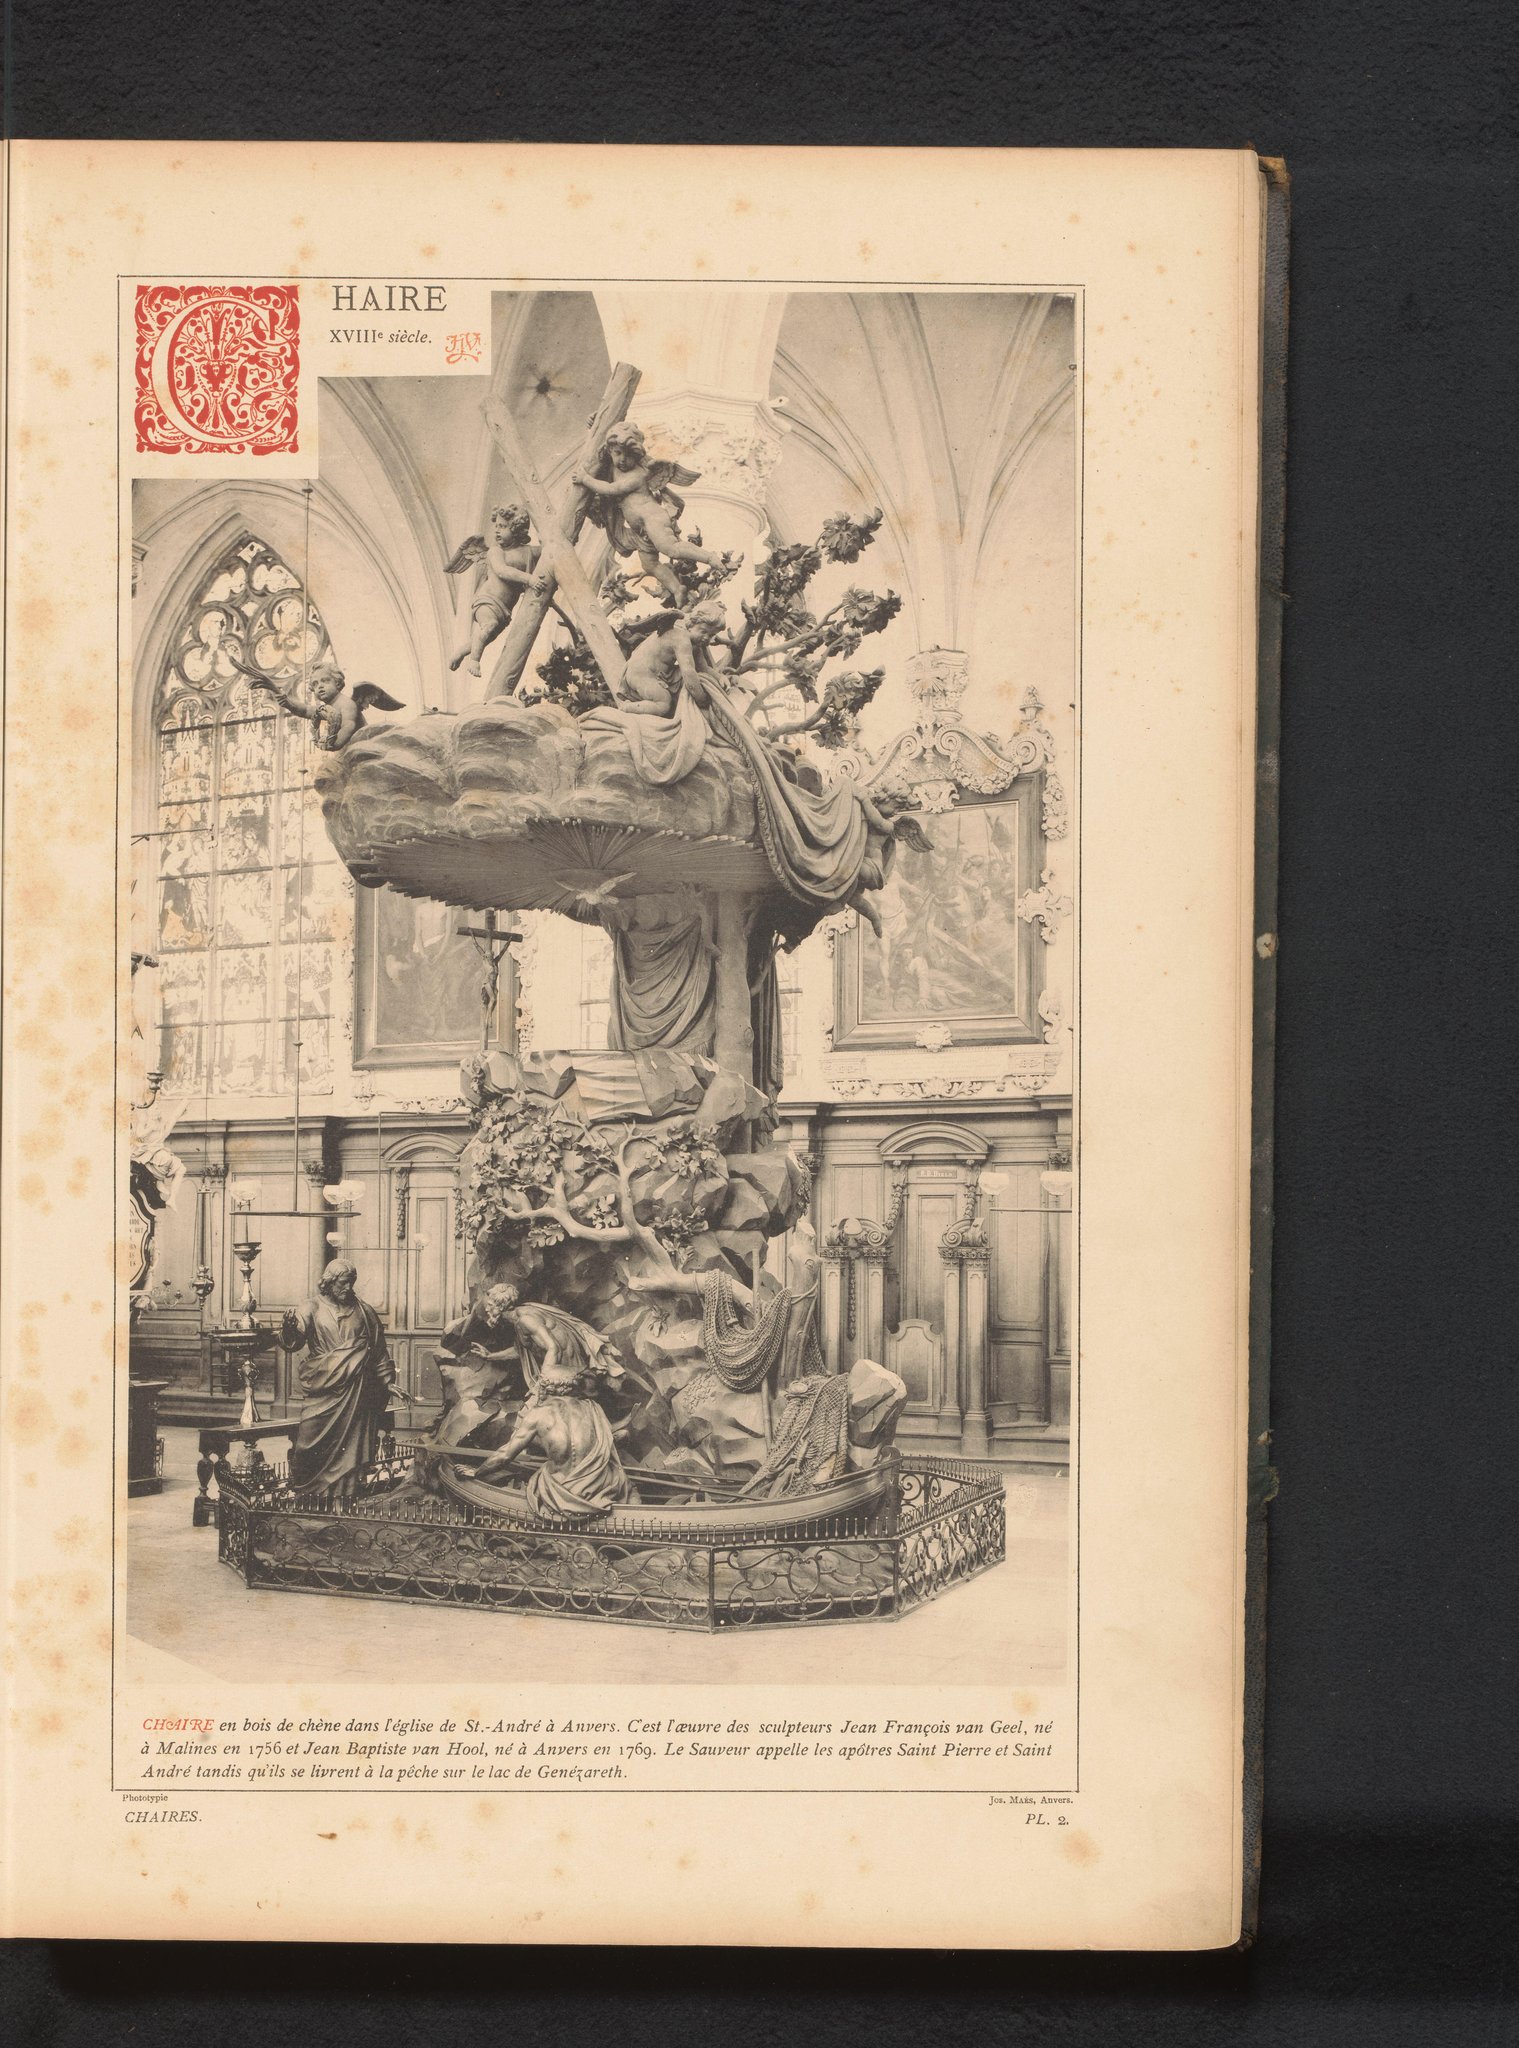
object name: photomechanical print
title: Eikenhouten preekstoel in de Sint-Andrieskerk in Antwerpen, België, ontworpen door Jean-François van Geel en Jean-Baptiste van Hool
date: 1882-1887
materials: paper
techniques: photograph, photolithography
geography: antwerp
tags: pulpit, ambo, chancel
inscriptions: inscription: ‘CHAIRE en bois (...)’, inscription: ‘CHAIRES. - PL. 2.’, monogram: ‘JJvY’